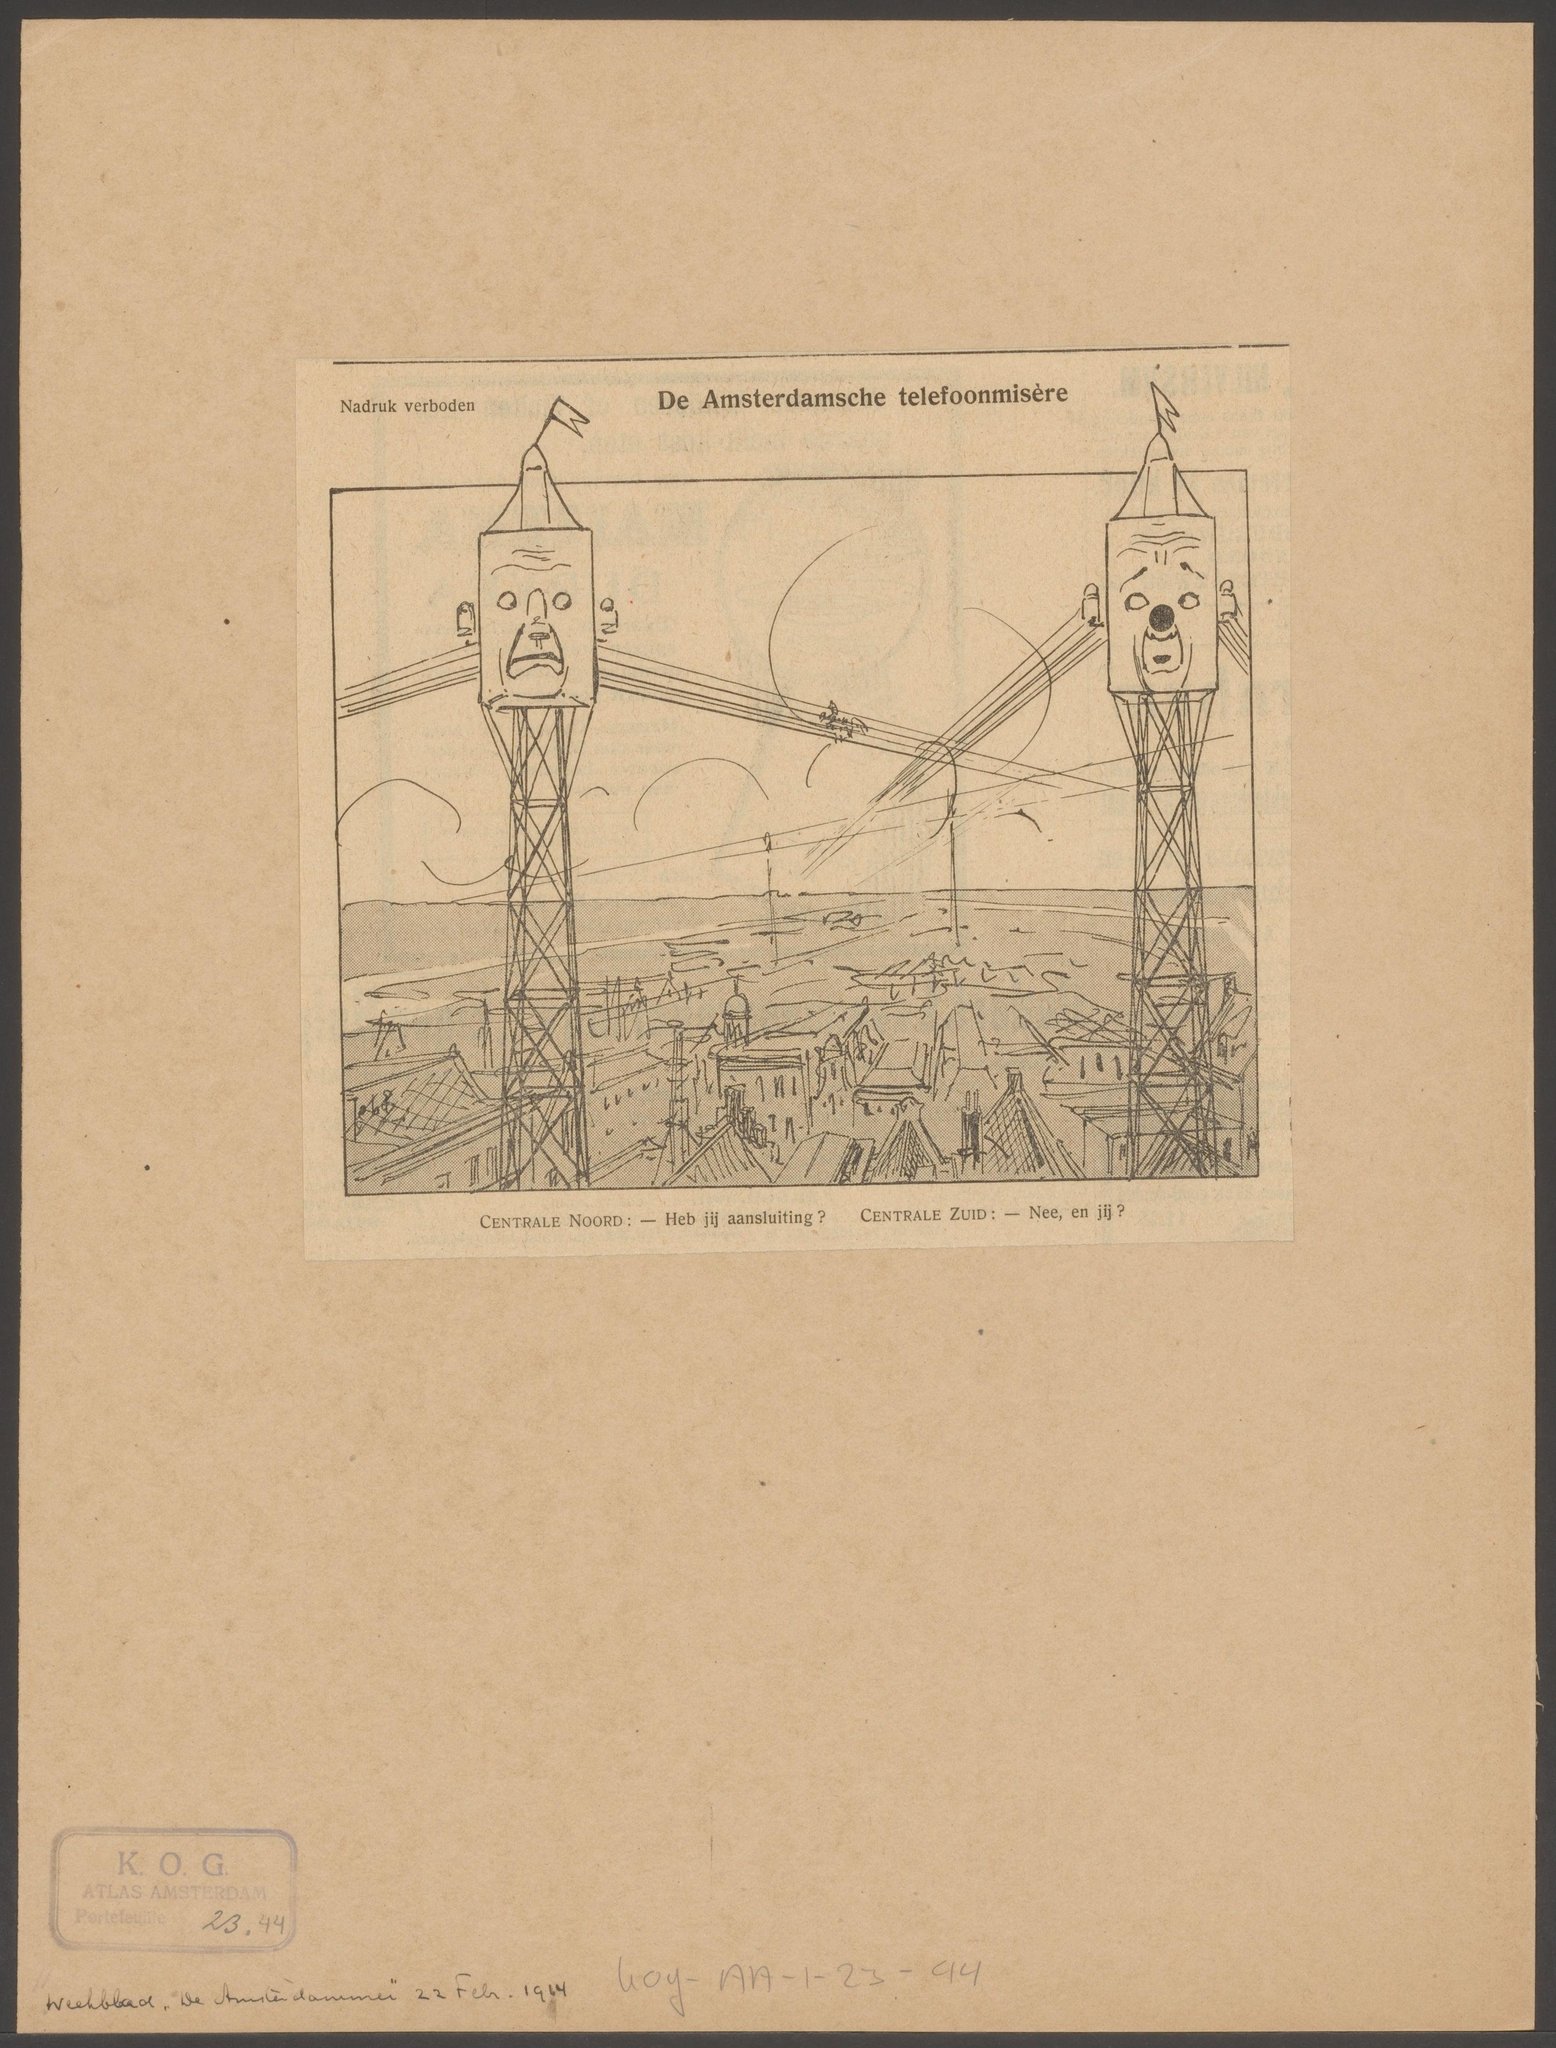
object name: photomechanical print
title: De Amsterdamsche telefoonmisère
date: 1914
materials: paper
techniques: letterpress printing, line block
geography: netherlands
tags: telegraph pole, telephone pole, pylons, power lines, amsterdam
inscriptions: collector's mark: Lugt 1641b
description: Prent uit: De Amsterdammer 38 (1914), nr. 1913, 22 februari 1914, p. 11.